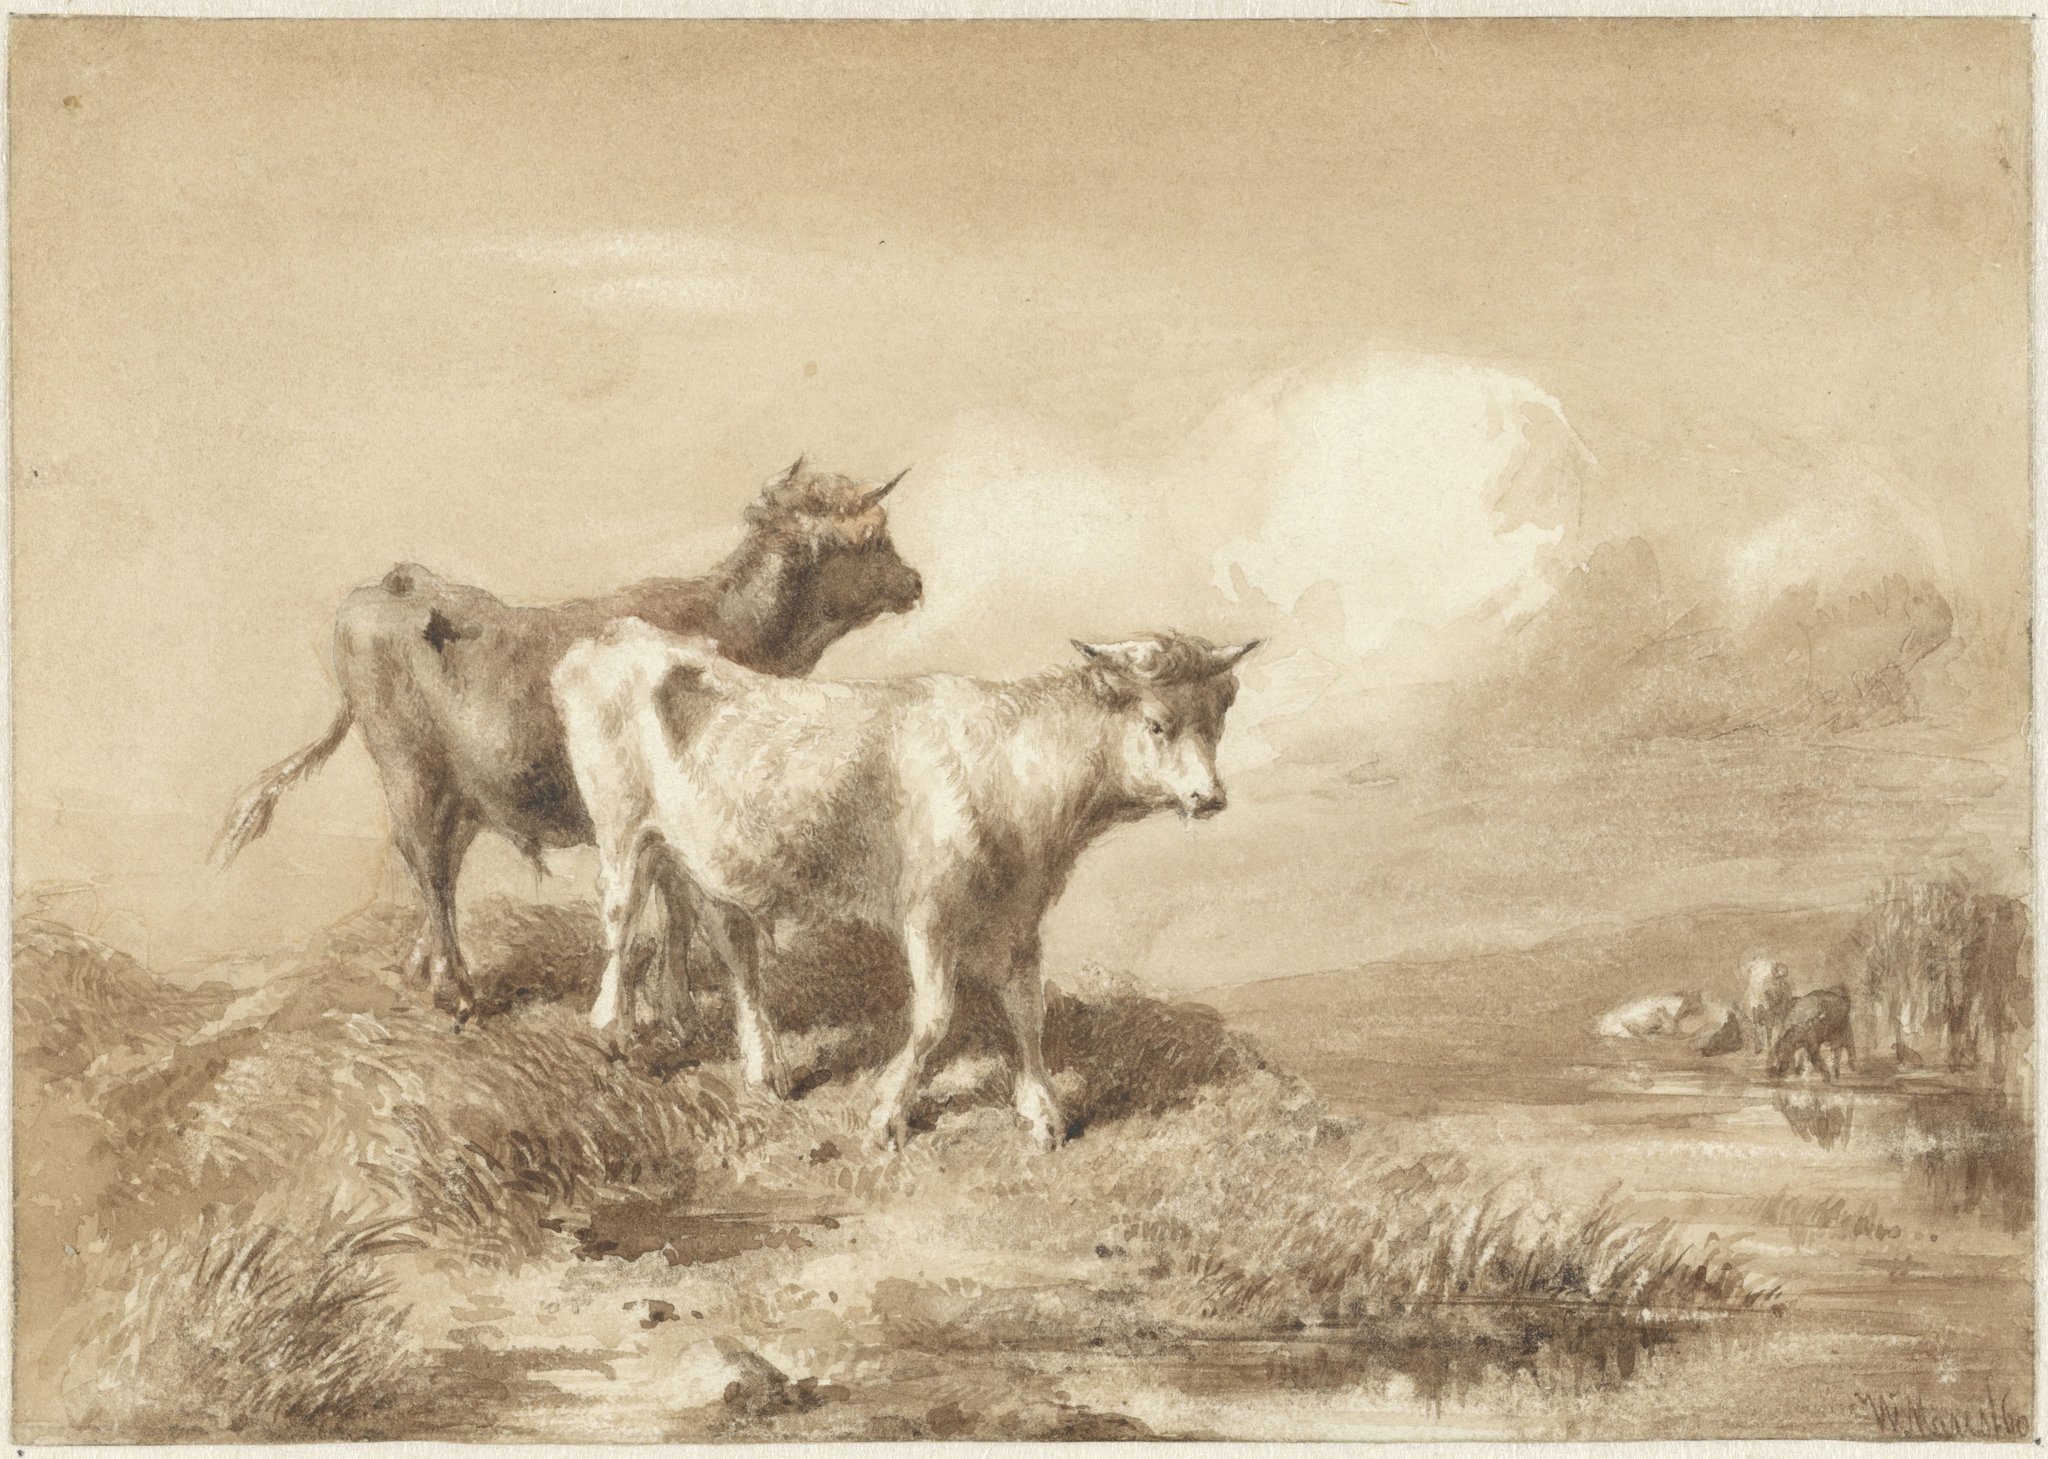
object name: drawing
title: Koeien bij het water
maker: willem maris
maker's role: draughtsman, painter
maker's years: 1844-1910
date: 1860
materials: paper, pencil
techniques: brush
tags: cow